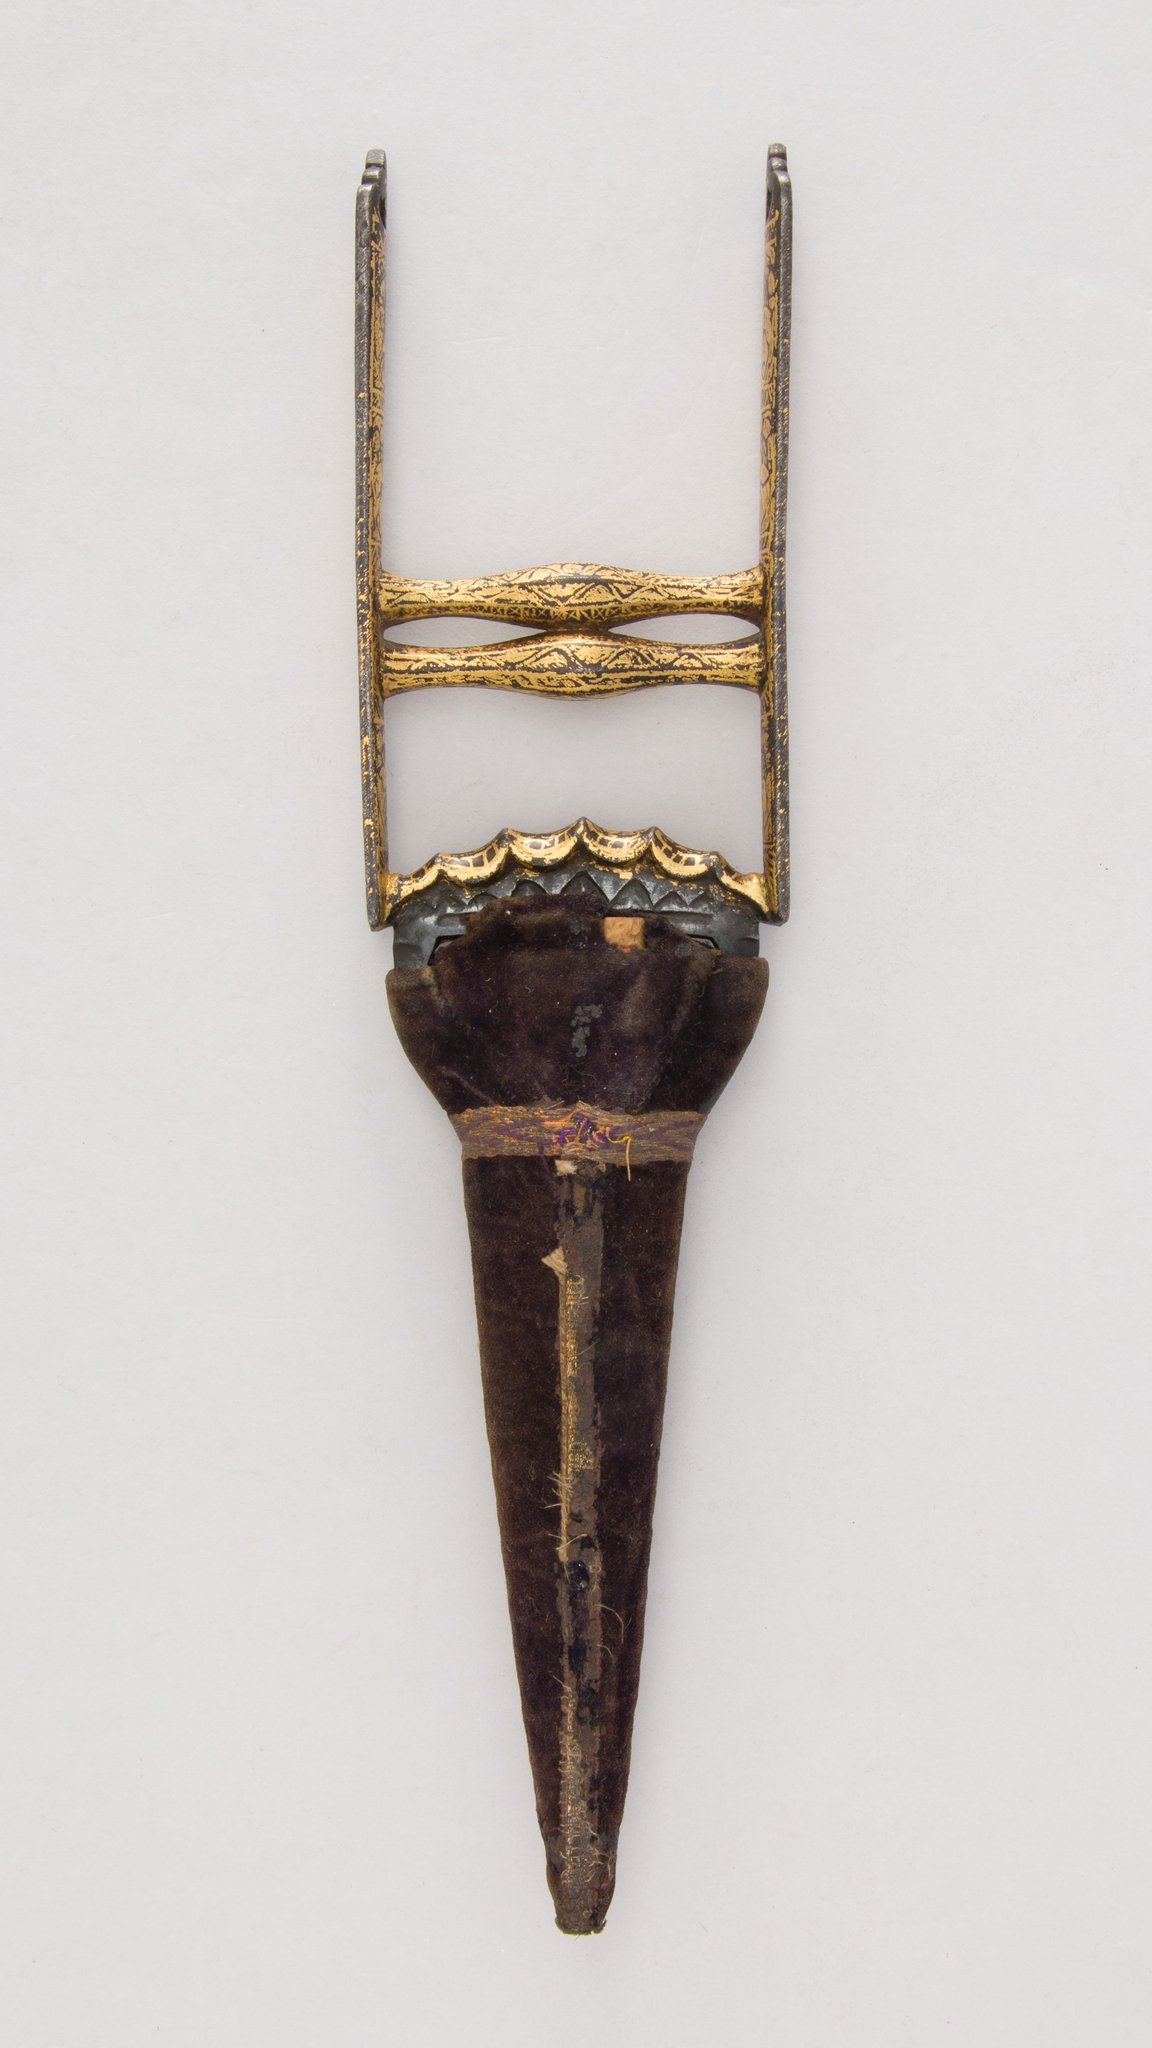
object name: dagger with sheath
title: Dagger (Katar) with Sheath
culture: indian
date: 1701-1800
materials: gold, steel, velvet, wood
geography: north india